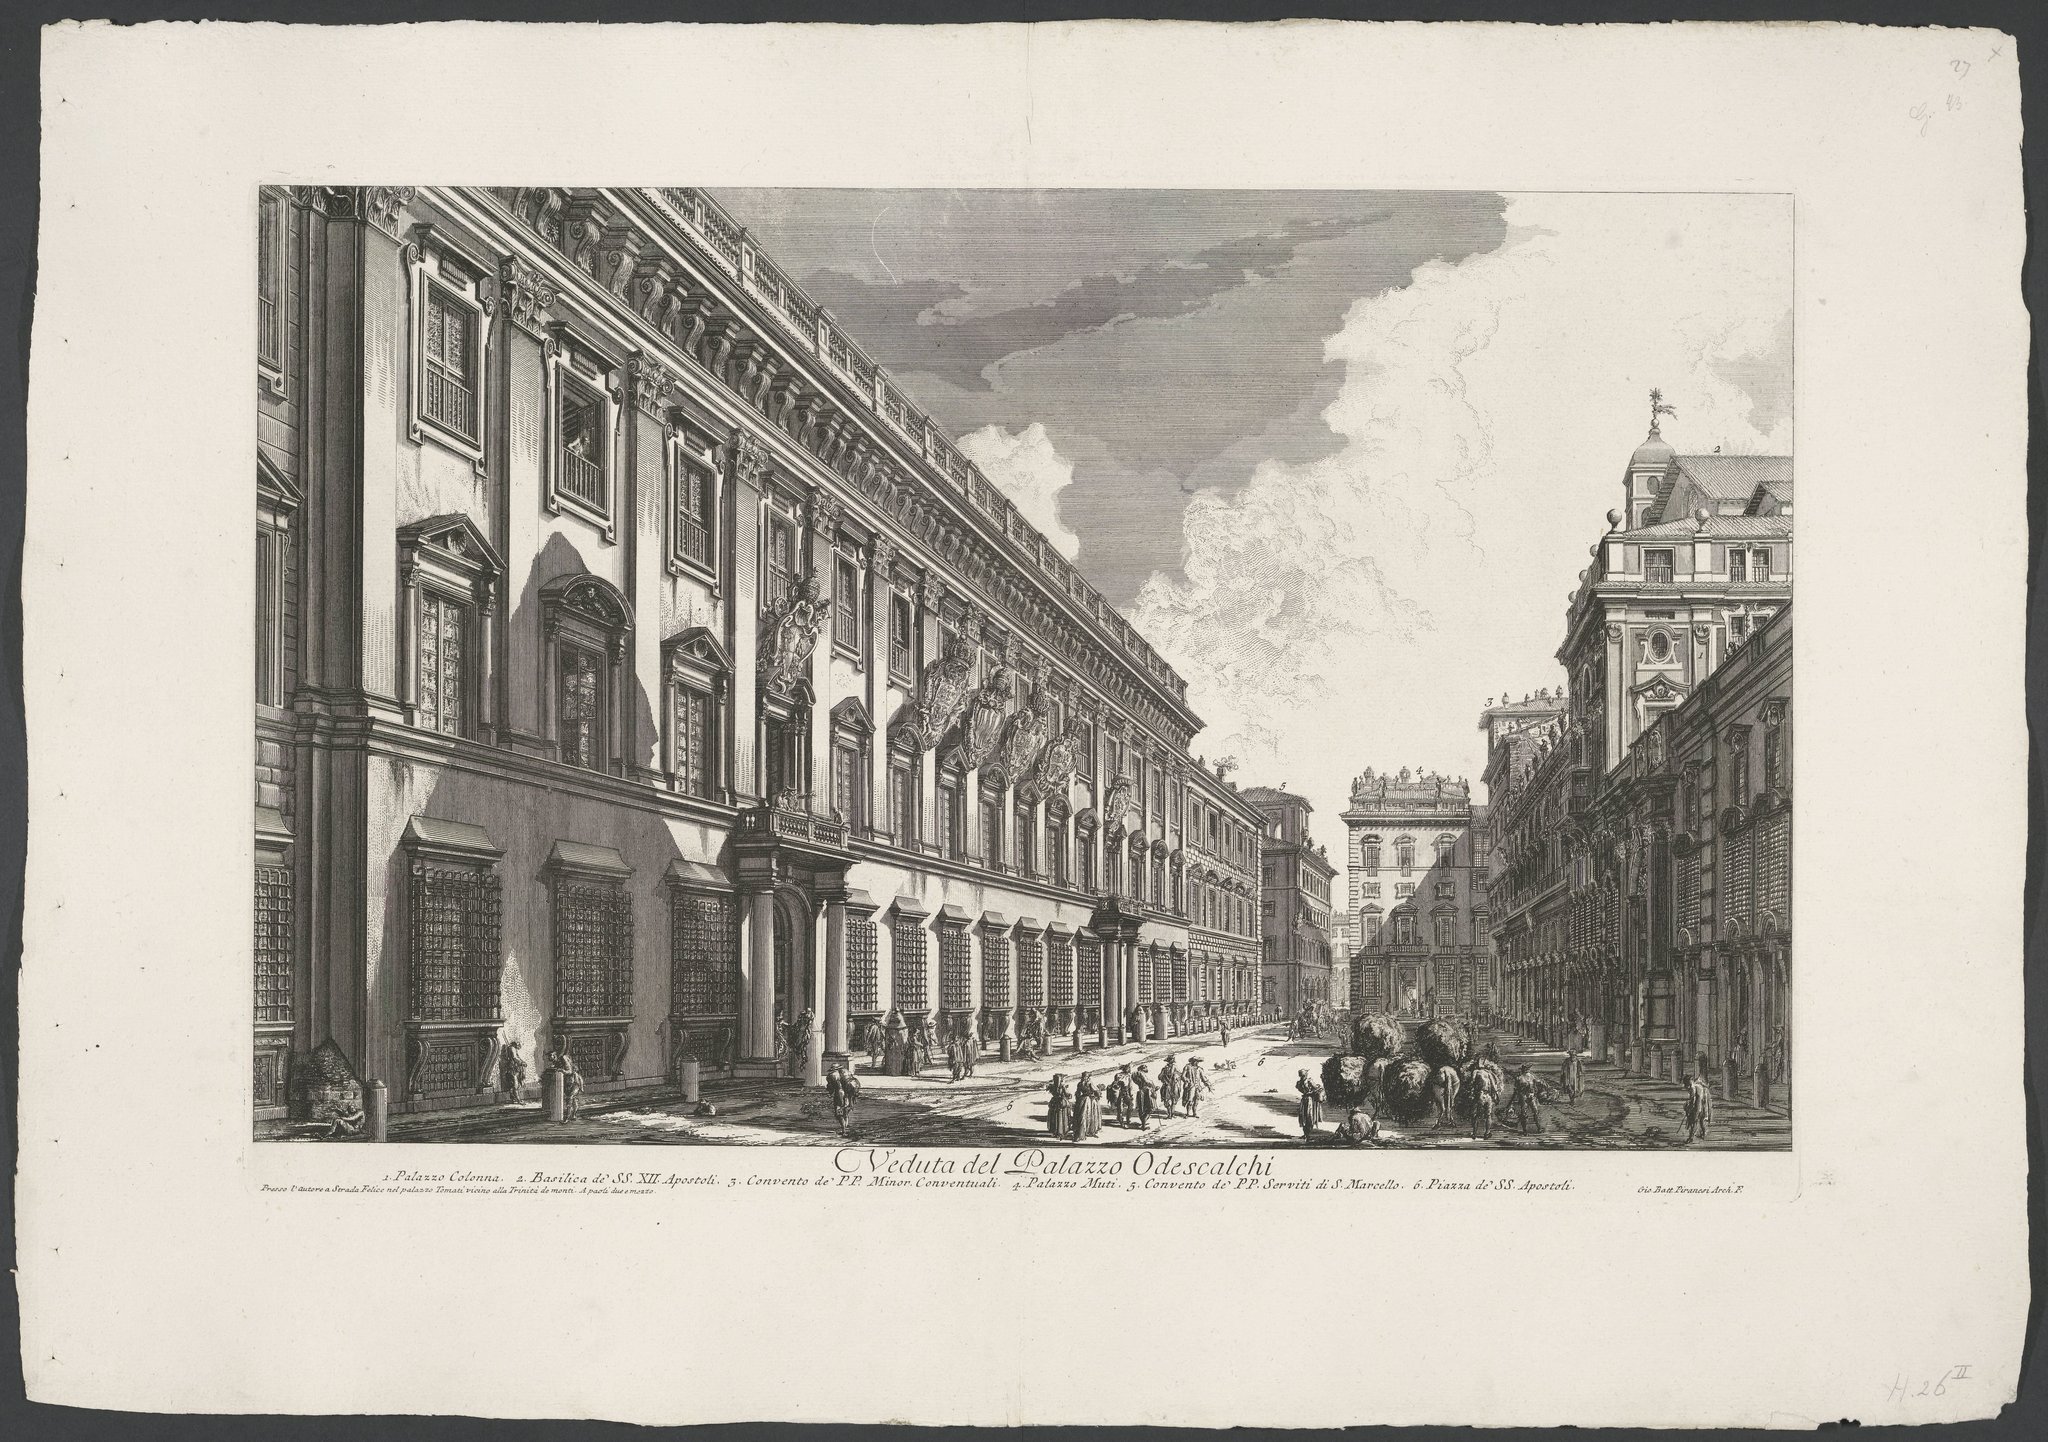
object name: print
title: Vedute di Roma disegnate ed incise da Giambattista Piranesi architetto Ve(nez)iano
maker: giovanni battista piranesi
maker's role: designer, draughtsman, print maker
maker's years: 1720-1778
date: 1748-1778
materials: paper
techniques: etching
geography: rome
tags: hôtel, i.e. small palace in city, rome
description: Deze prent maakt deel uit van de serie 'Vedute di Roma'. Piranesi werkte aan deze 135 platen tellende serie tussen 1748 en zijn dood in 1778. Francesco Piranesi voegde later nog twee prenten toe aan de reeks van zijn vader.